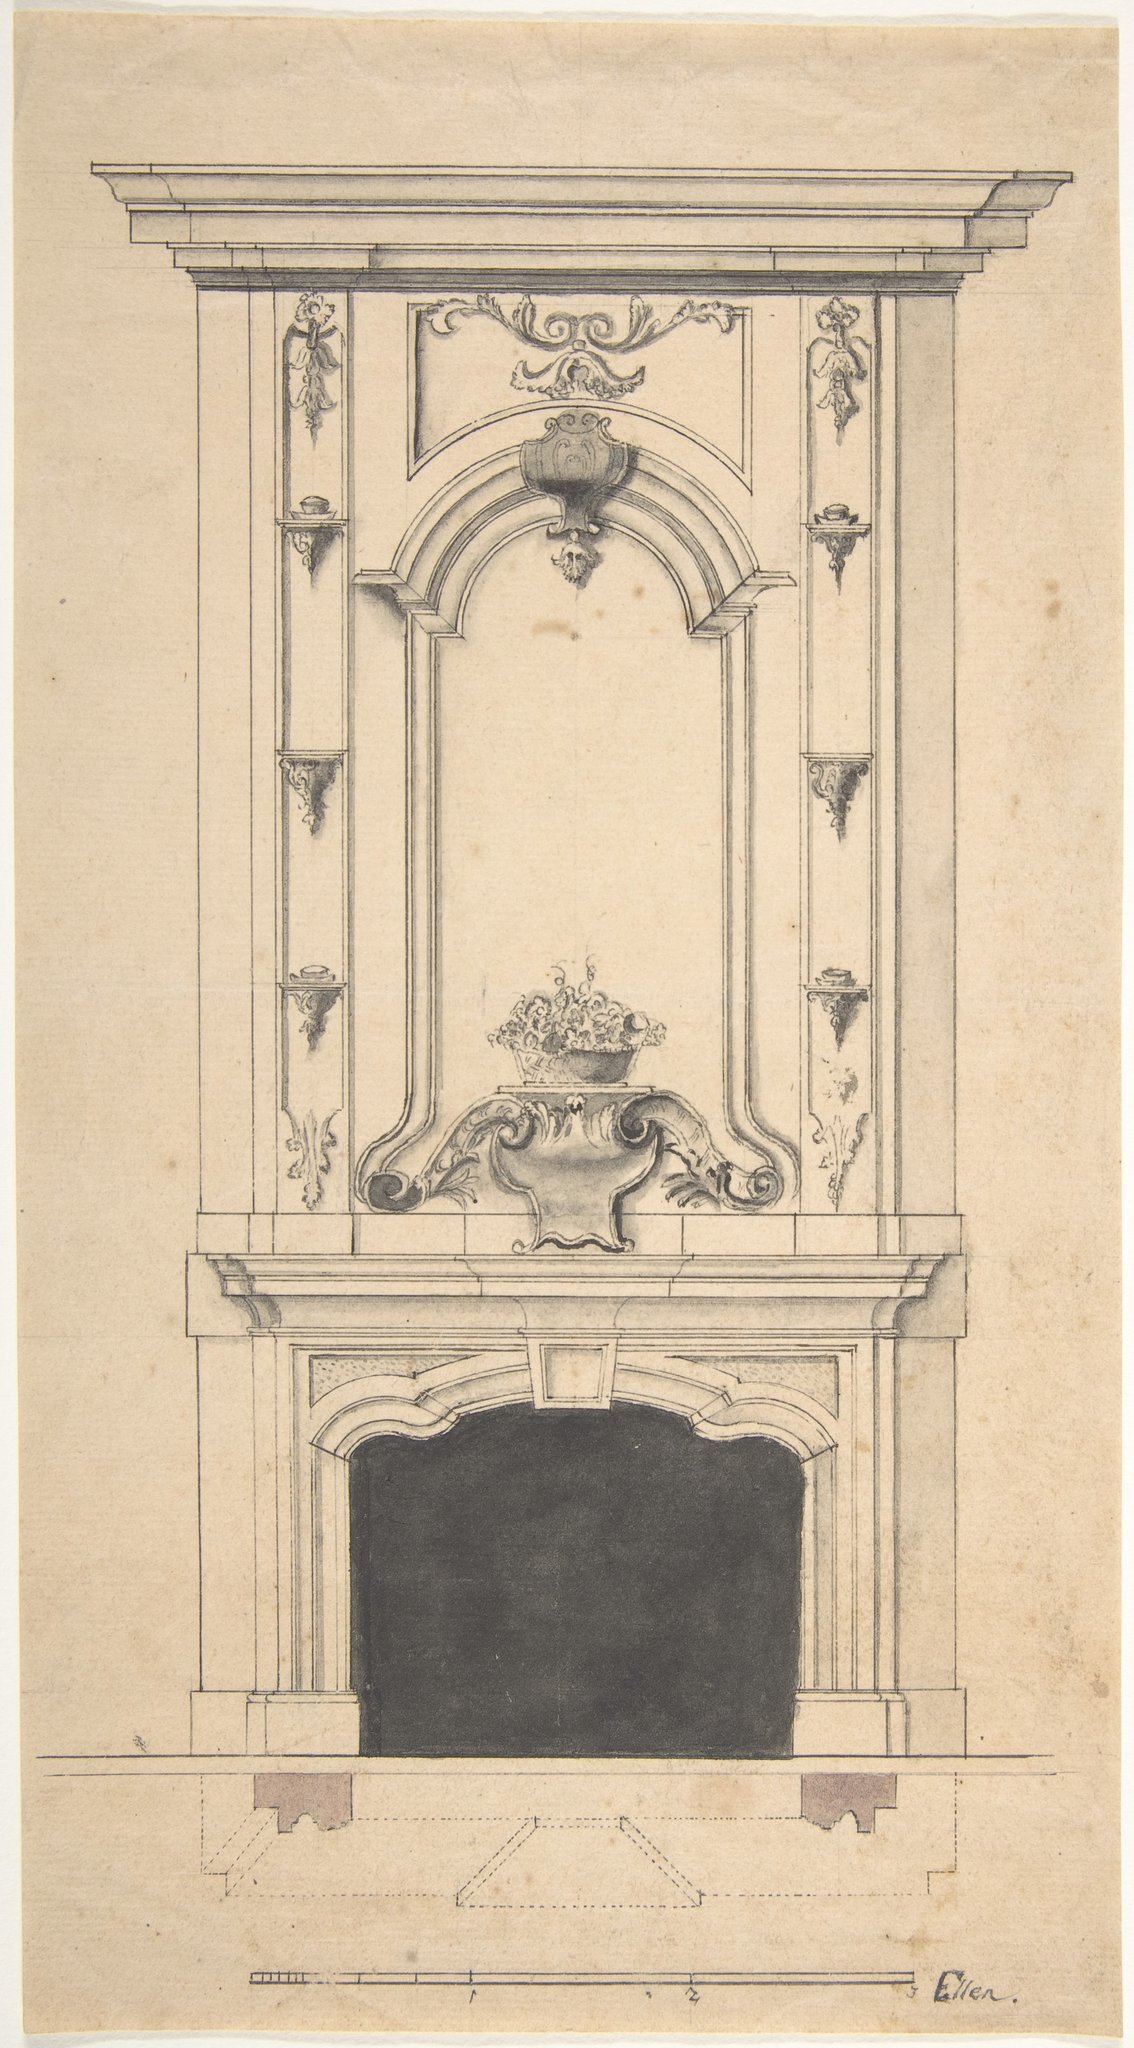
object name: drawing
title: Design for a Chimney Piece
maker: anonymous, british, 18th century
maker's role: artist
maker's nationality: british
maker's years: 1700-1800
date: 1701-1800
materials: ink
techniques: brush, pen, wash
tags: architecture